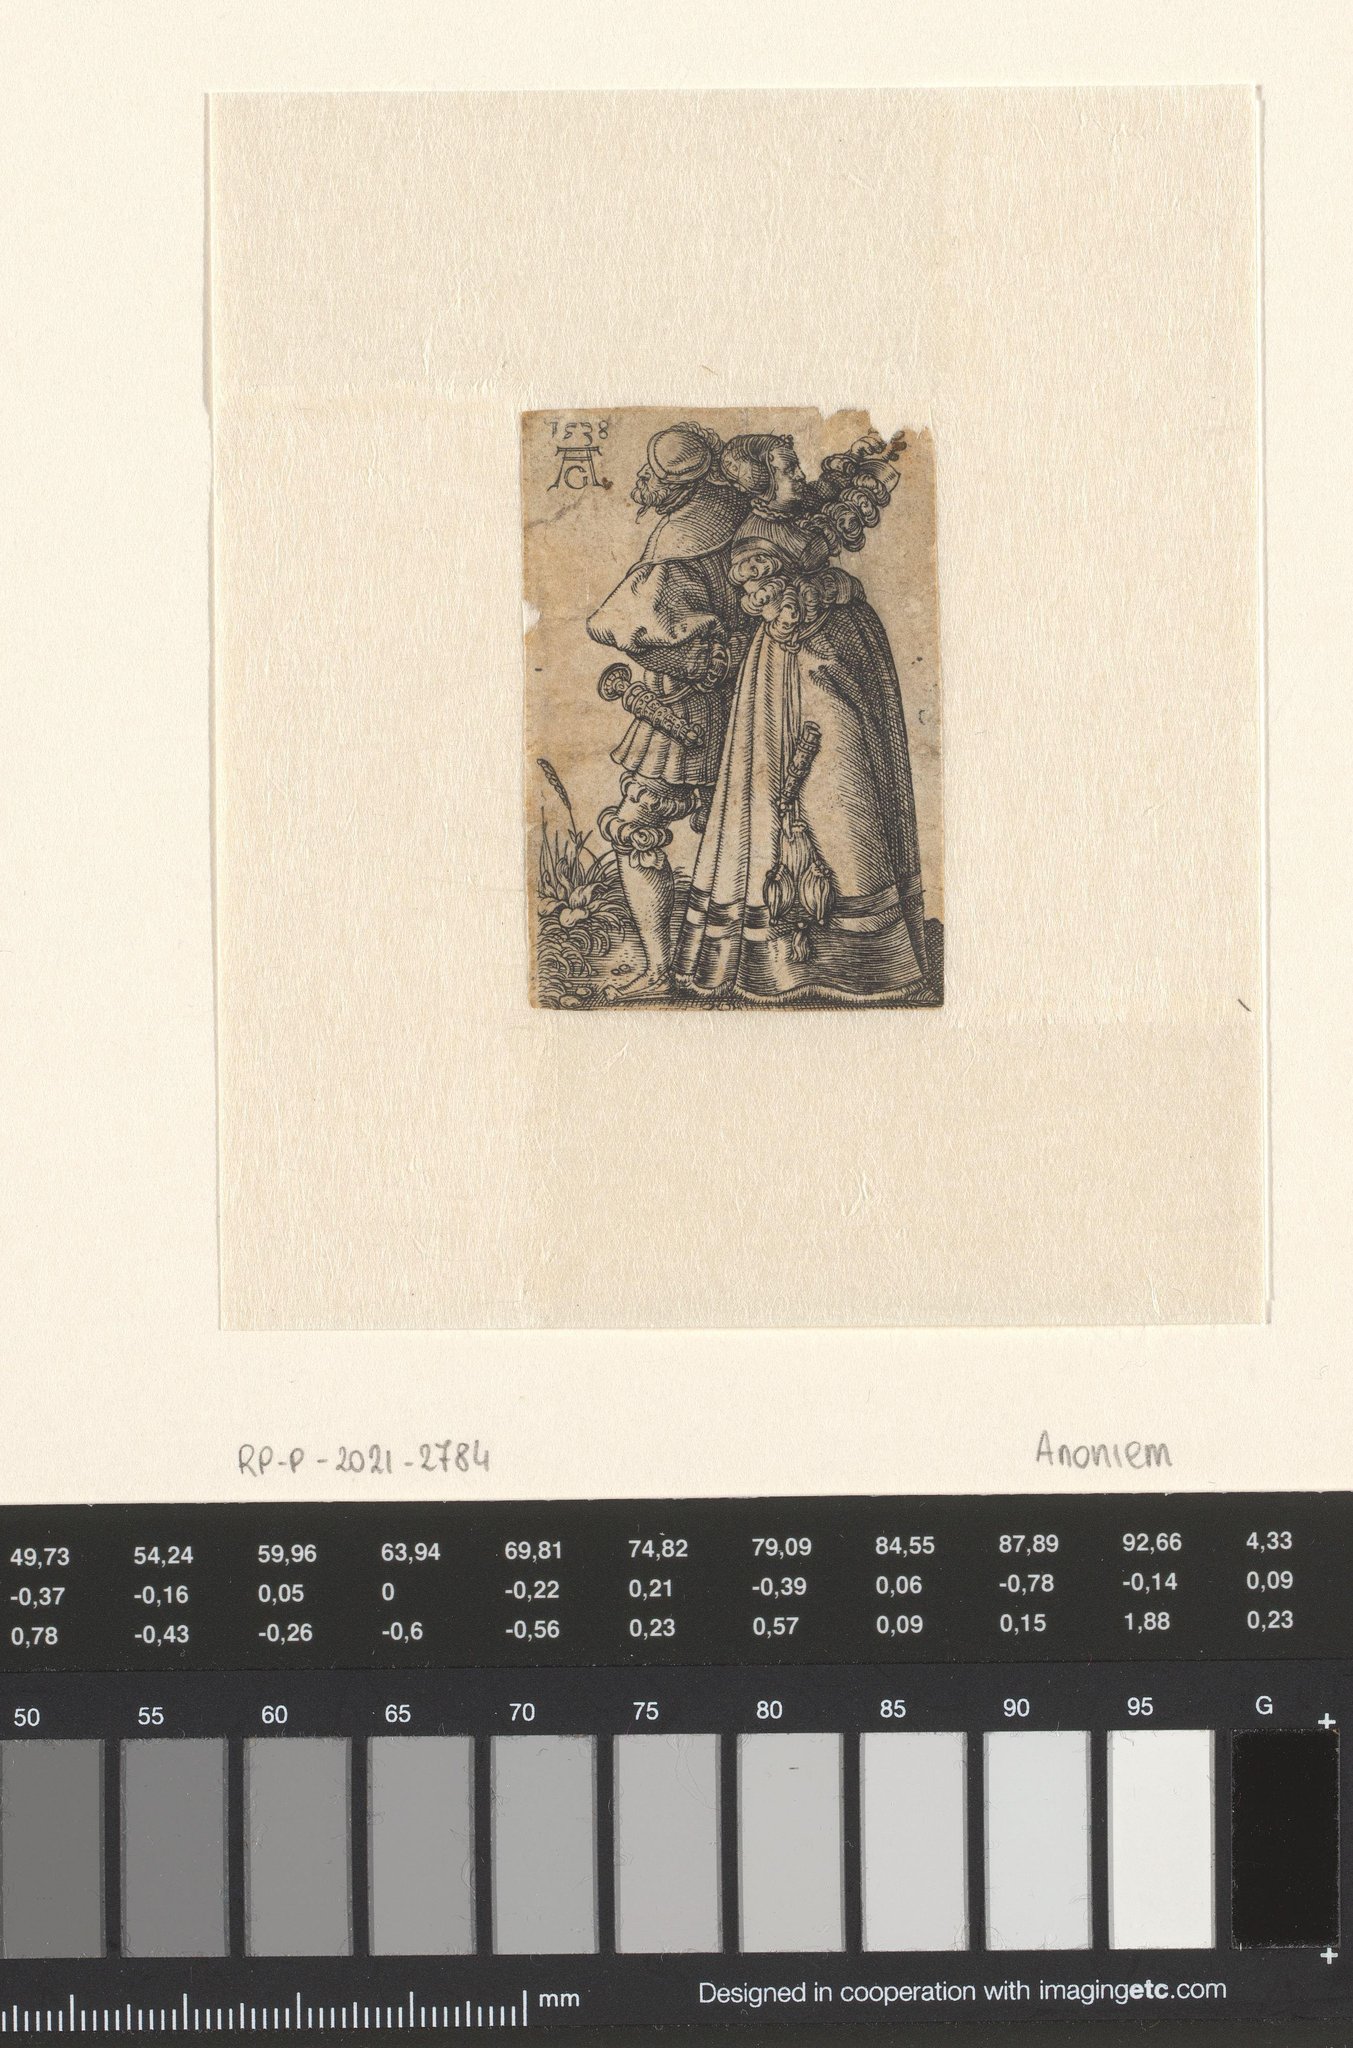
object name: print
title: Dansend paar met ruggen tegen elkaar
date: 1538-1580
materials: paper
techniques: engraving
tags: dancing at wedding feast, one pair dancing; man and woman dancing as a couple